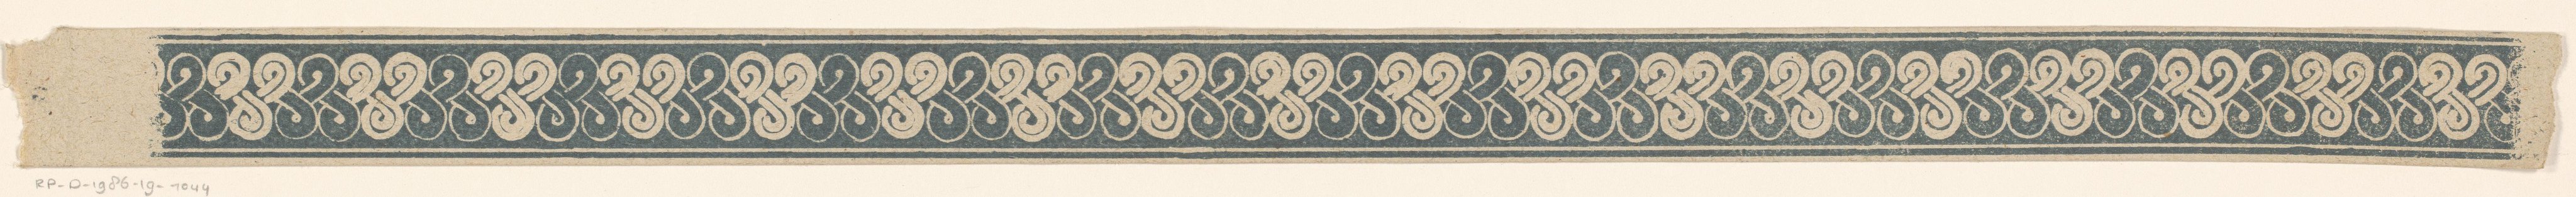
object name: print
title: Randversiering met patroon van gevlochten ornamenten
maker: reinier willem petrus de vries (1874-1953)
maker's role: draughtsman, print maker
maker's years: 1874-1953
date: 1884-1952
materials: paper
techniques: lithograph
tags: interlace ~ ornament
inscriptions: collector's mark: ‘R:MVS.’